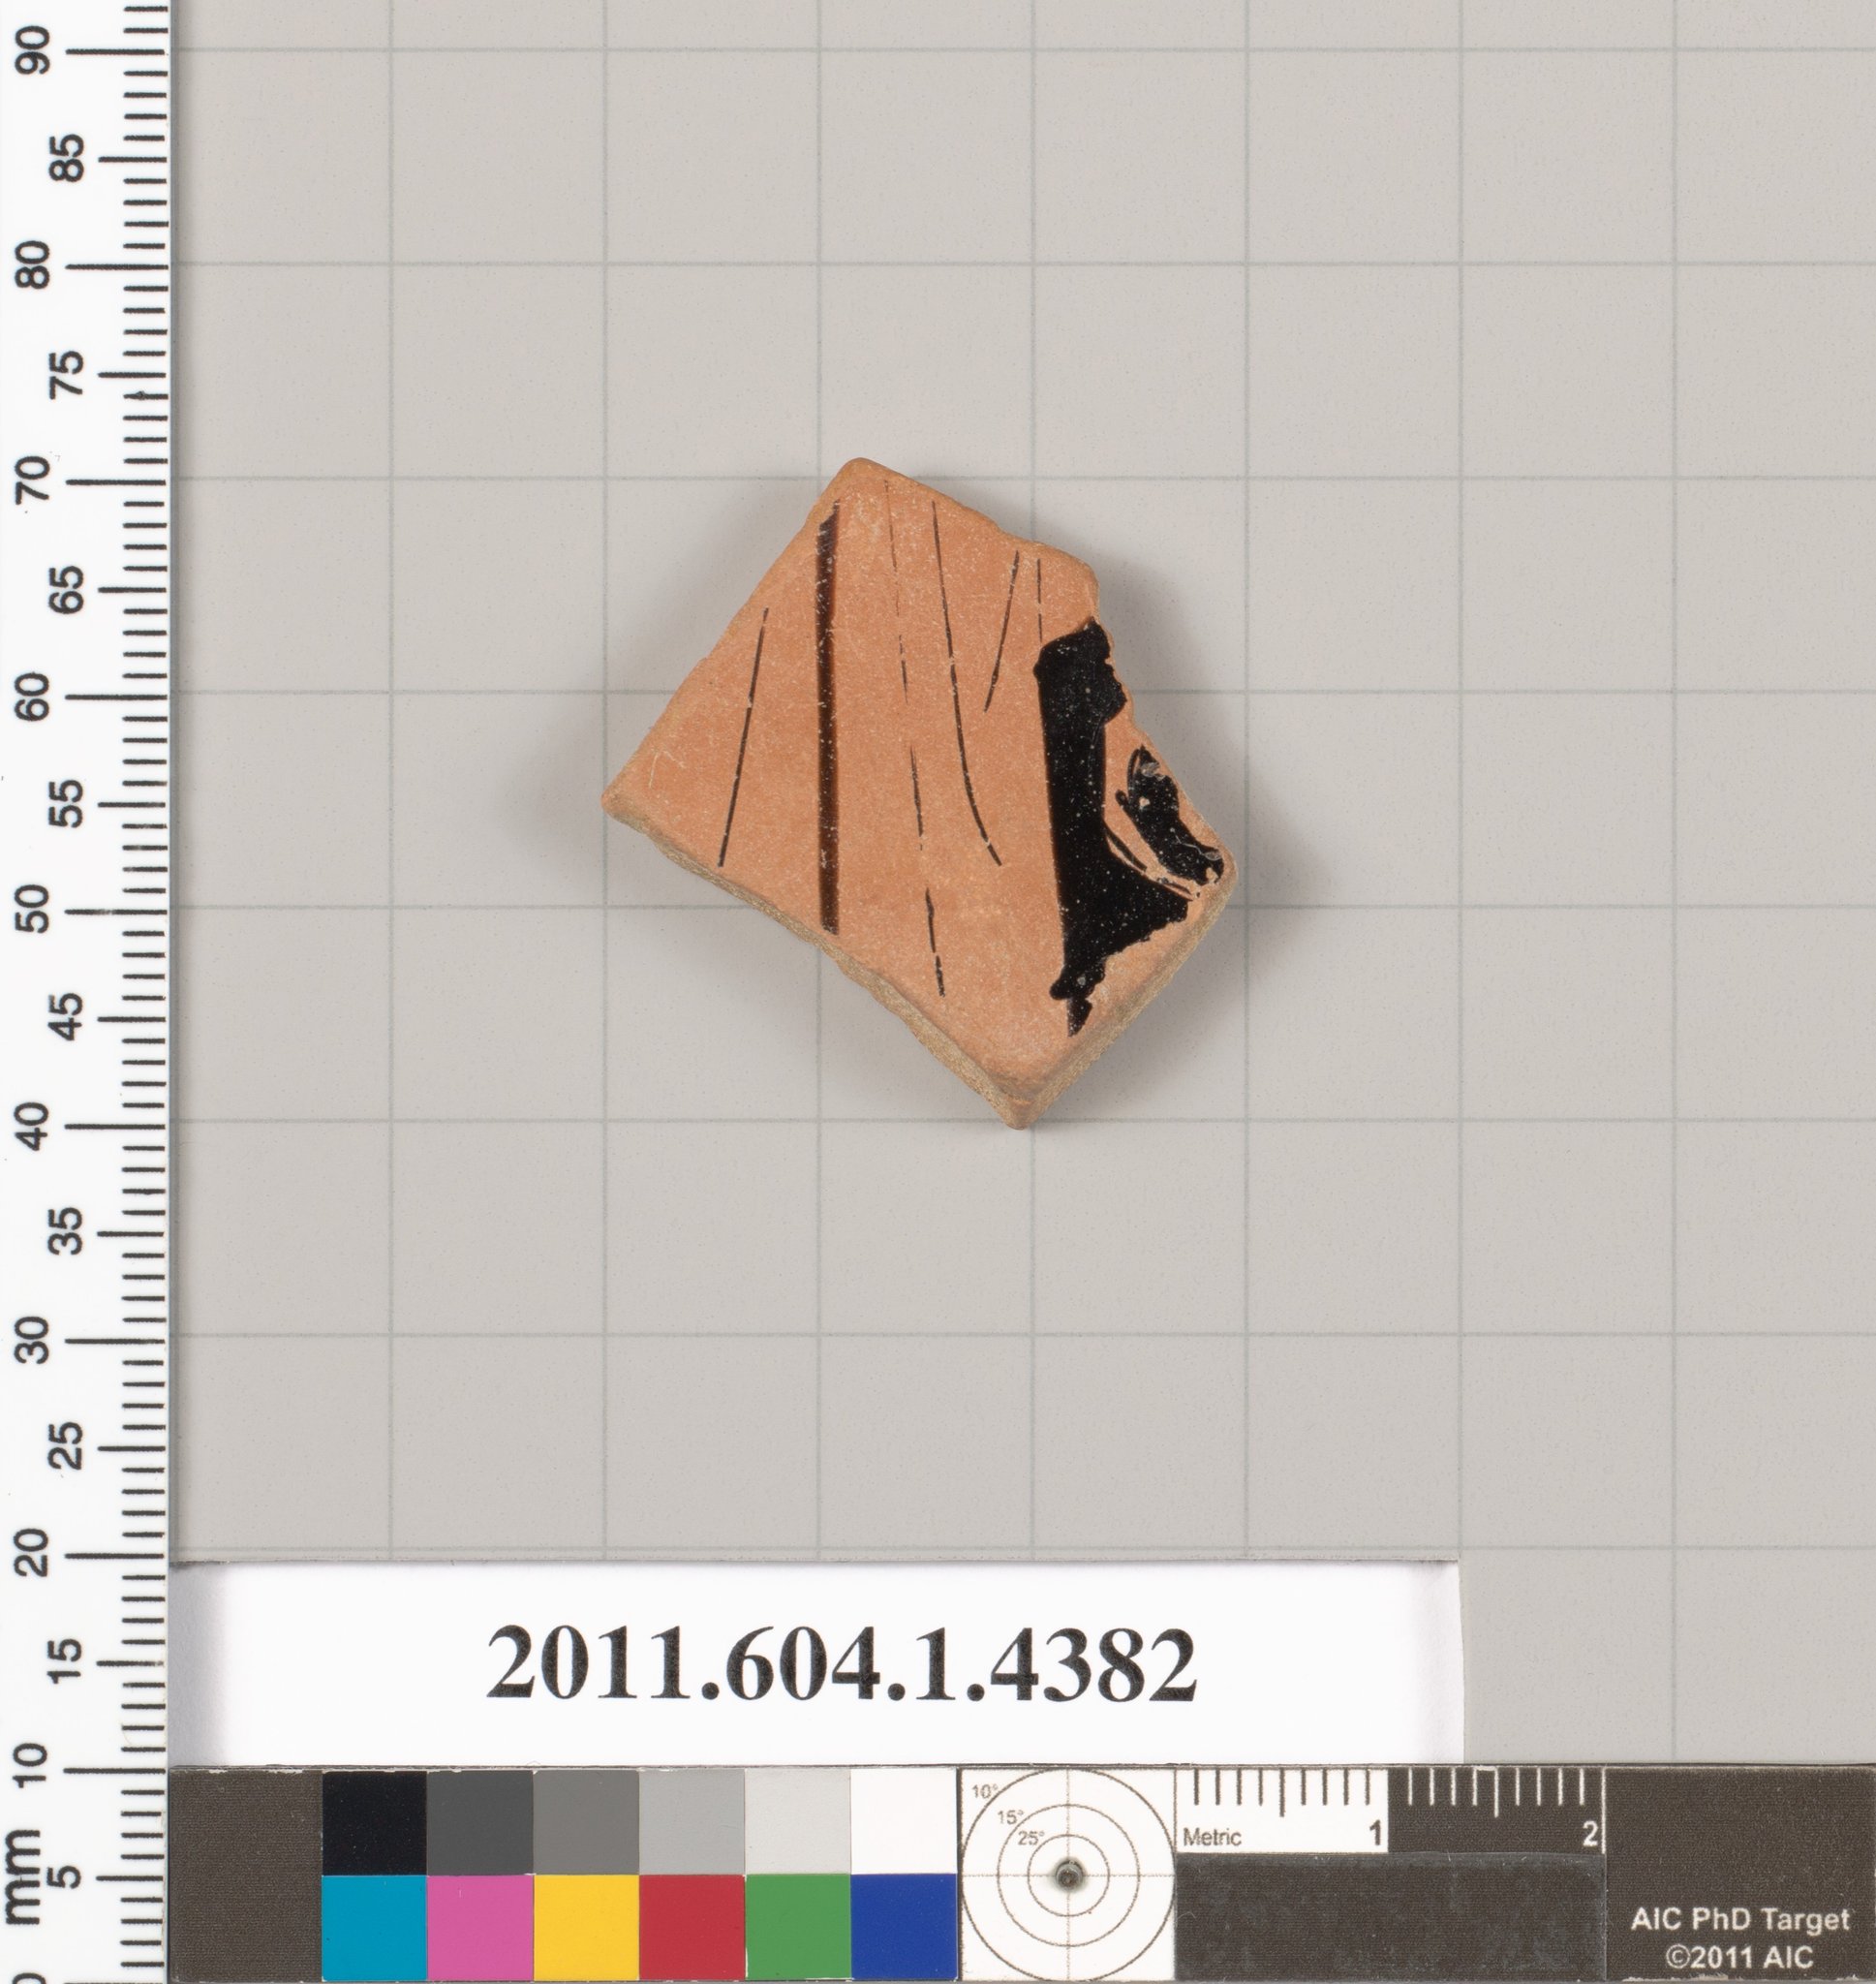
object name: kylix fragment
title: Terracotta fragment of a kylix (drinking cup)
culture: greek, attic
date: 467-435 BCE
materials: terracotta